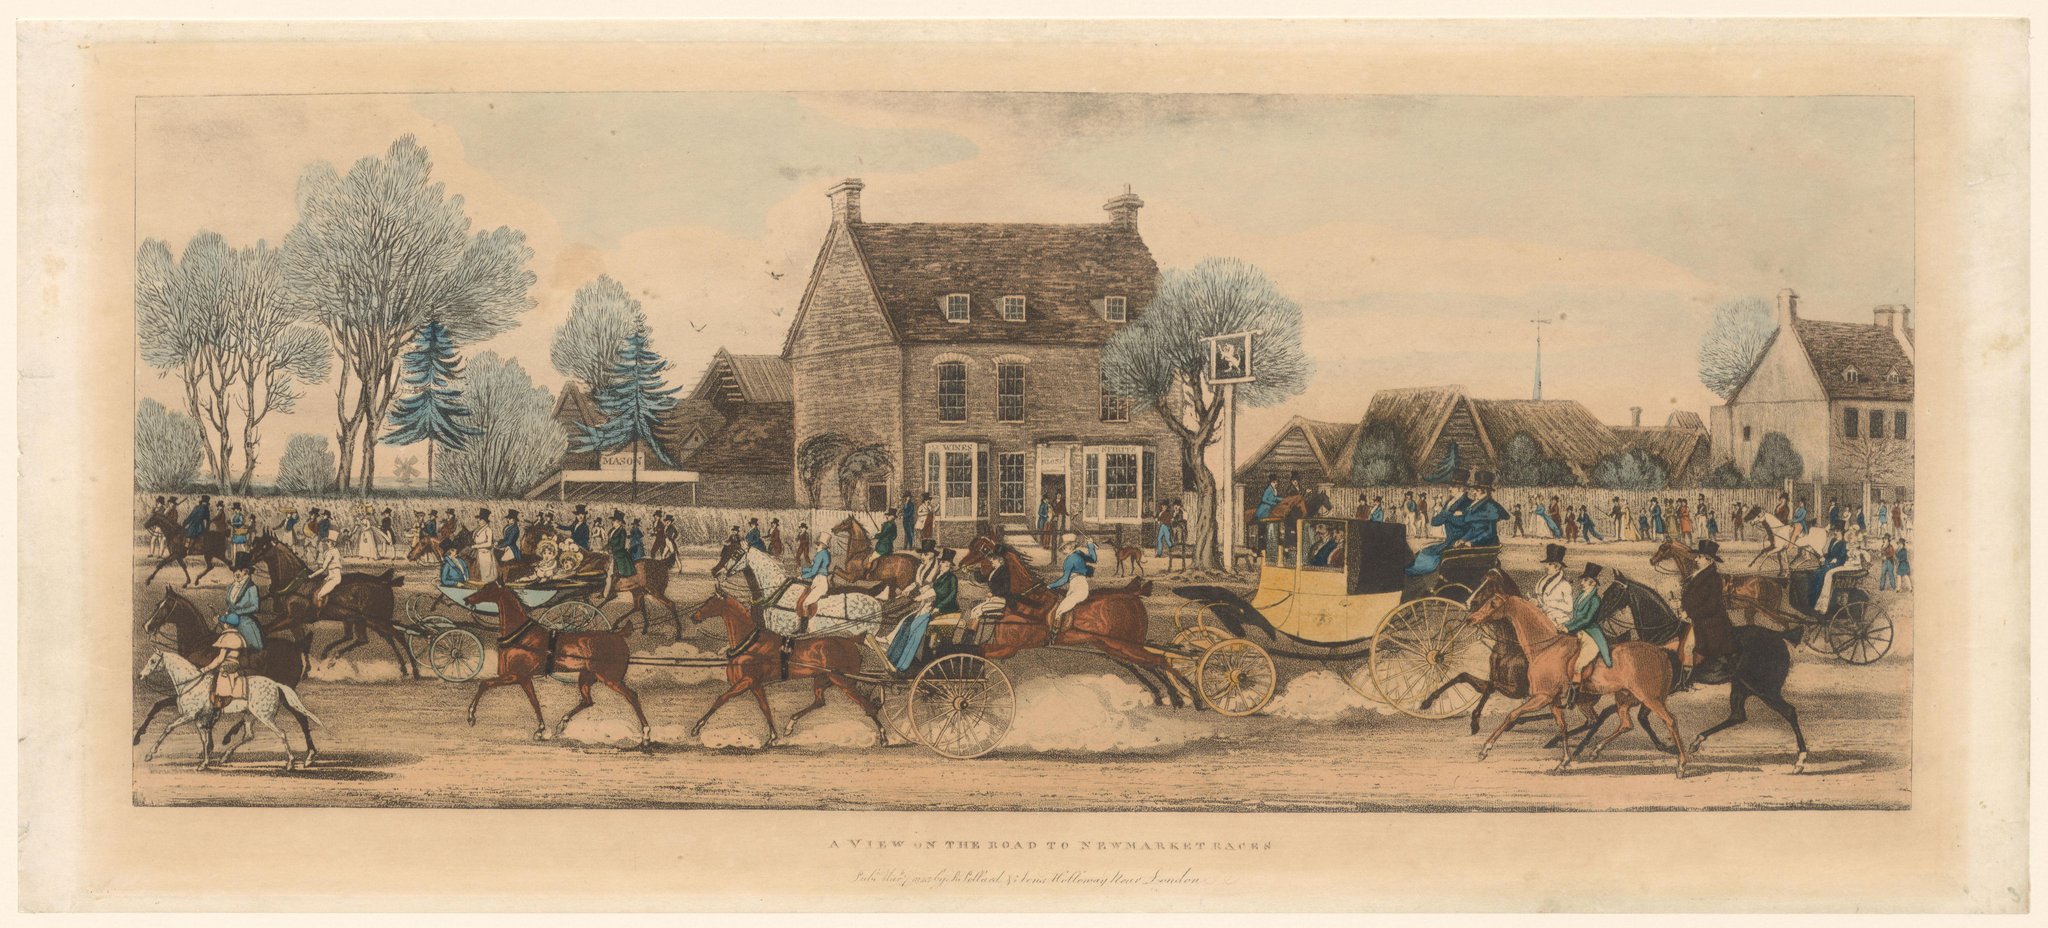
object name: print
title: Paardenrace te Newmarket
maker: robert pollard (i)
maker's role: print maker, publisher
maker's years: 1755-1838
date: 1803-1825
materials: paper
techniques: aquatint, etching, hand coloring, roulette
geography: london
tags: wagon racing (with horses), horse-racing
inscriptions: collector's mark: Lugt 2228